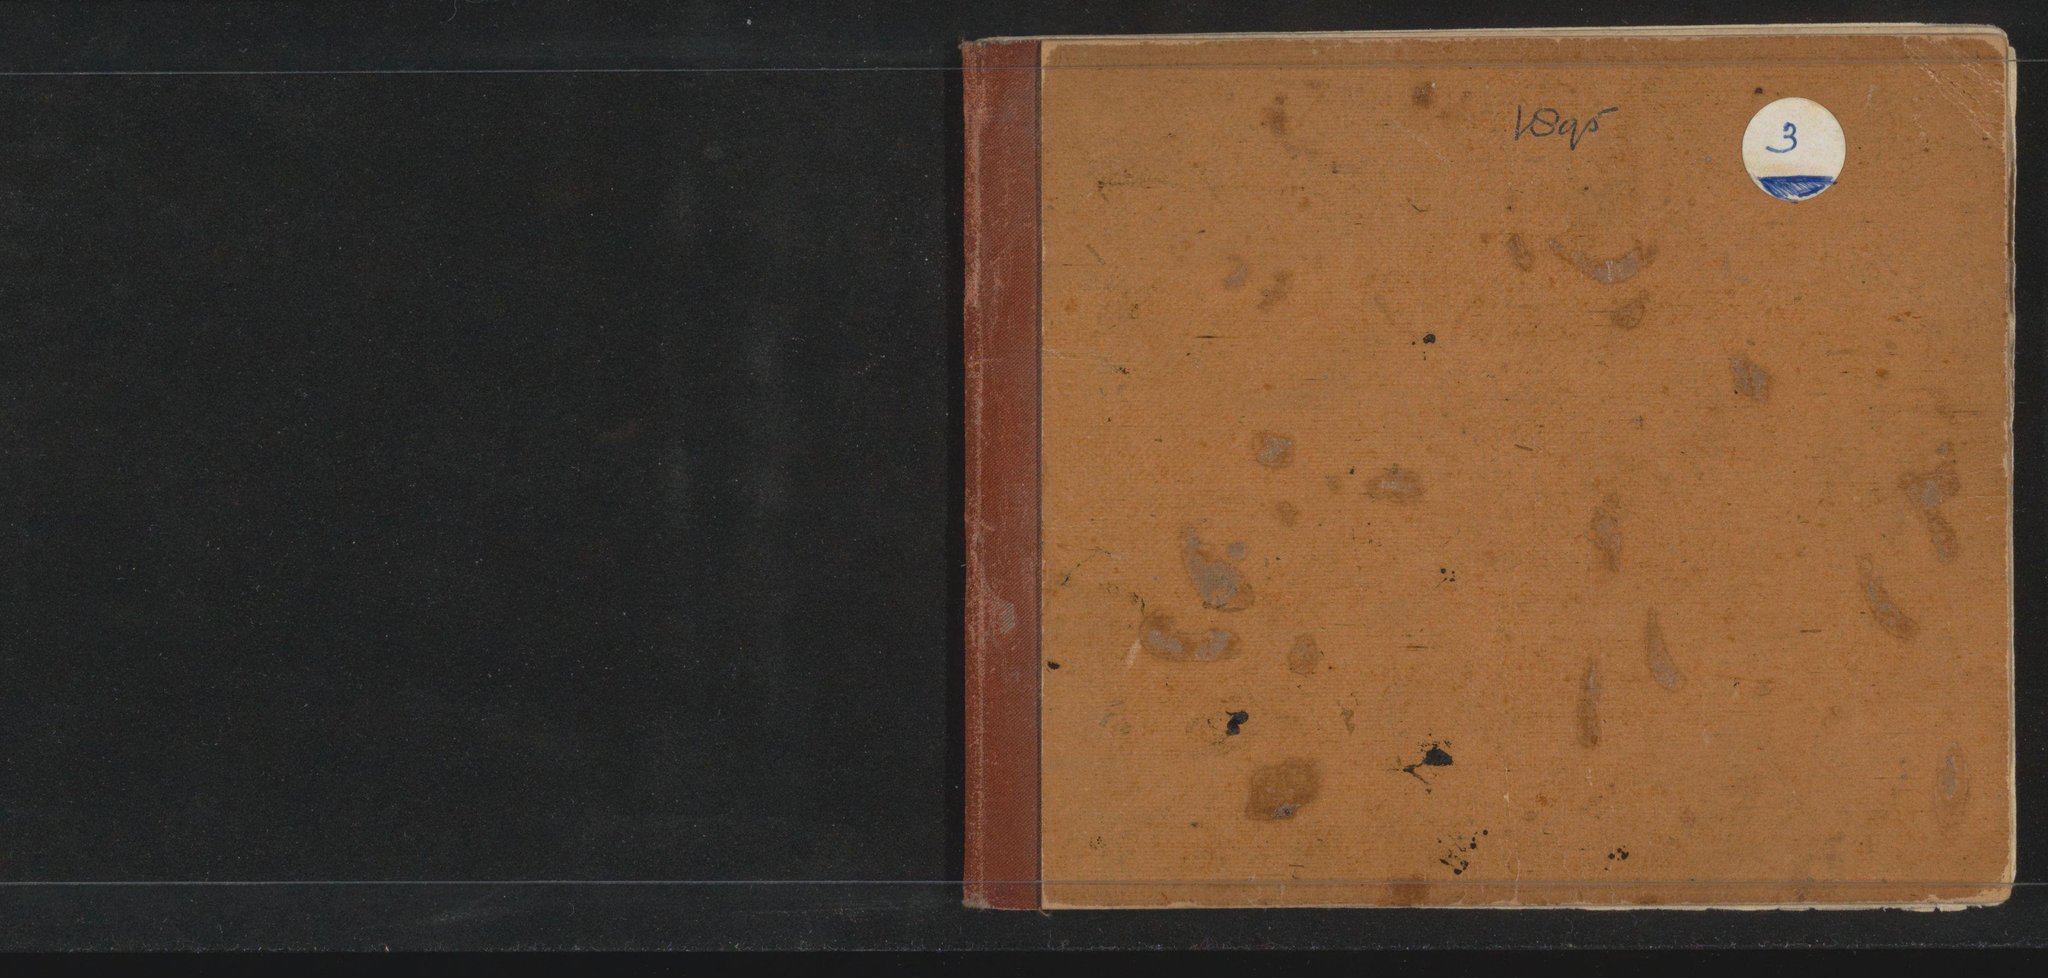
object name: sketchbook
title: Schetsboek met 11 bladen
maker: carel adolph lion cachet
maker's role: draughtsman, print maker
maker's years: 1864-1945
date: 1895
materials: cardboard, chalk, linen, paper, pencil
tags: head (human), anatomy (non-medical), hand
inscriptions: collector's mark: Lugt 2228a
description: Schetsboek bestaande uit 11 bladen met voornamelijk koppen, figuren en handen. Tevens enkele fantasievoorstellingen.